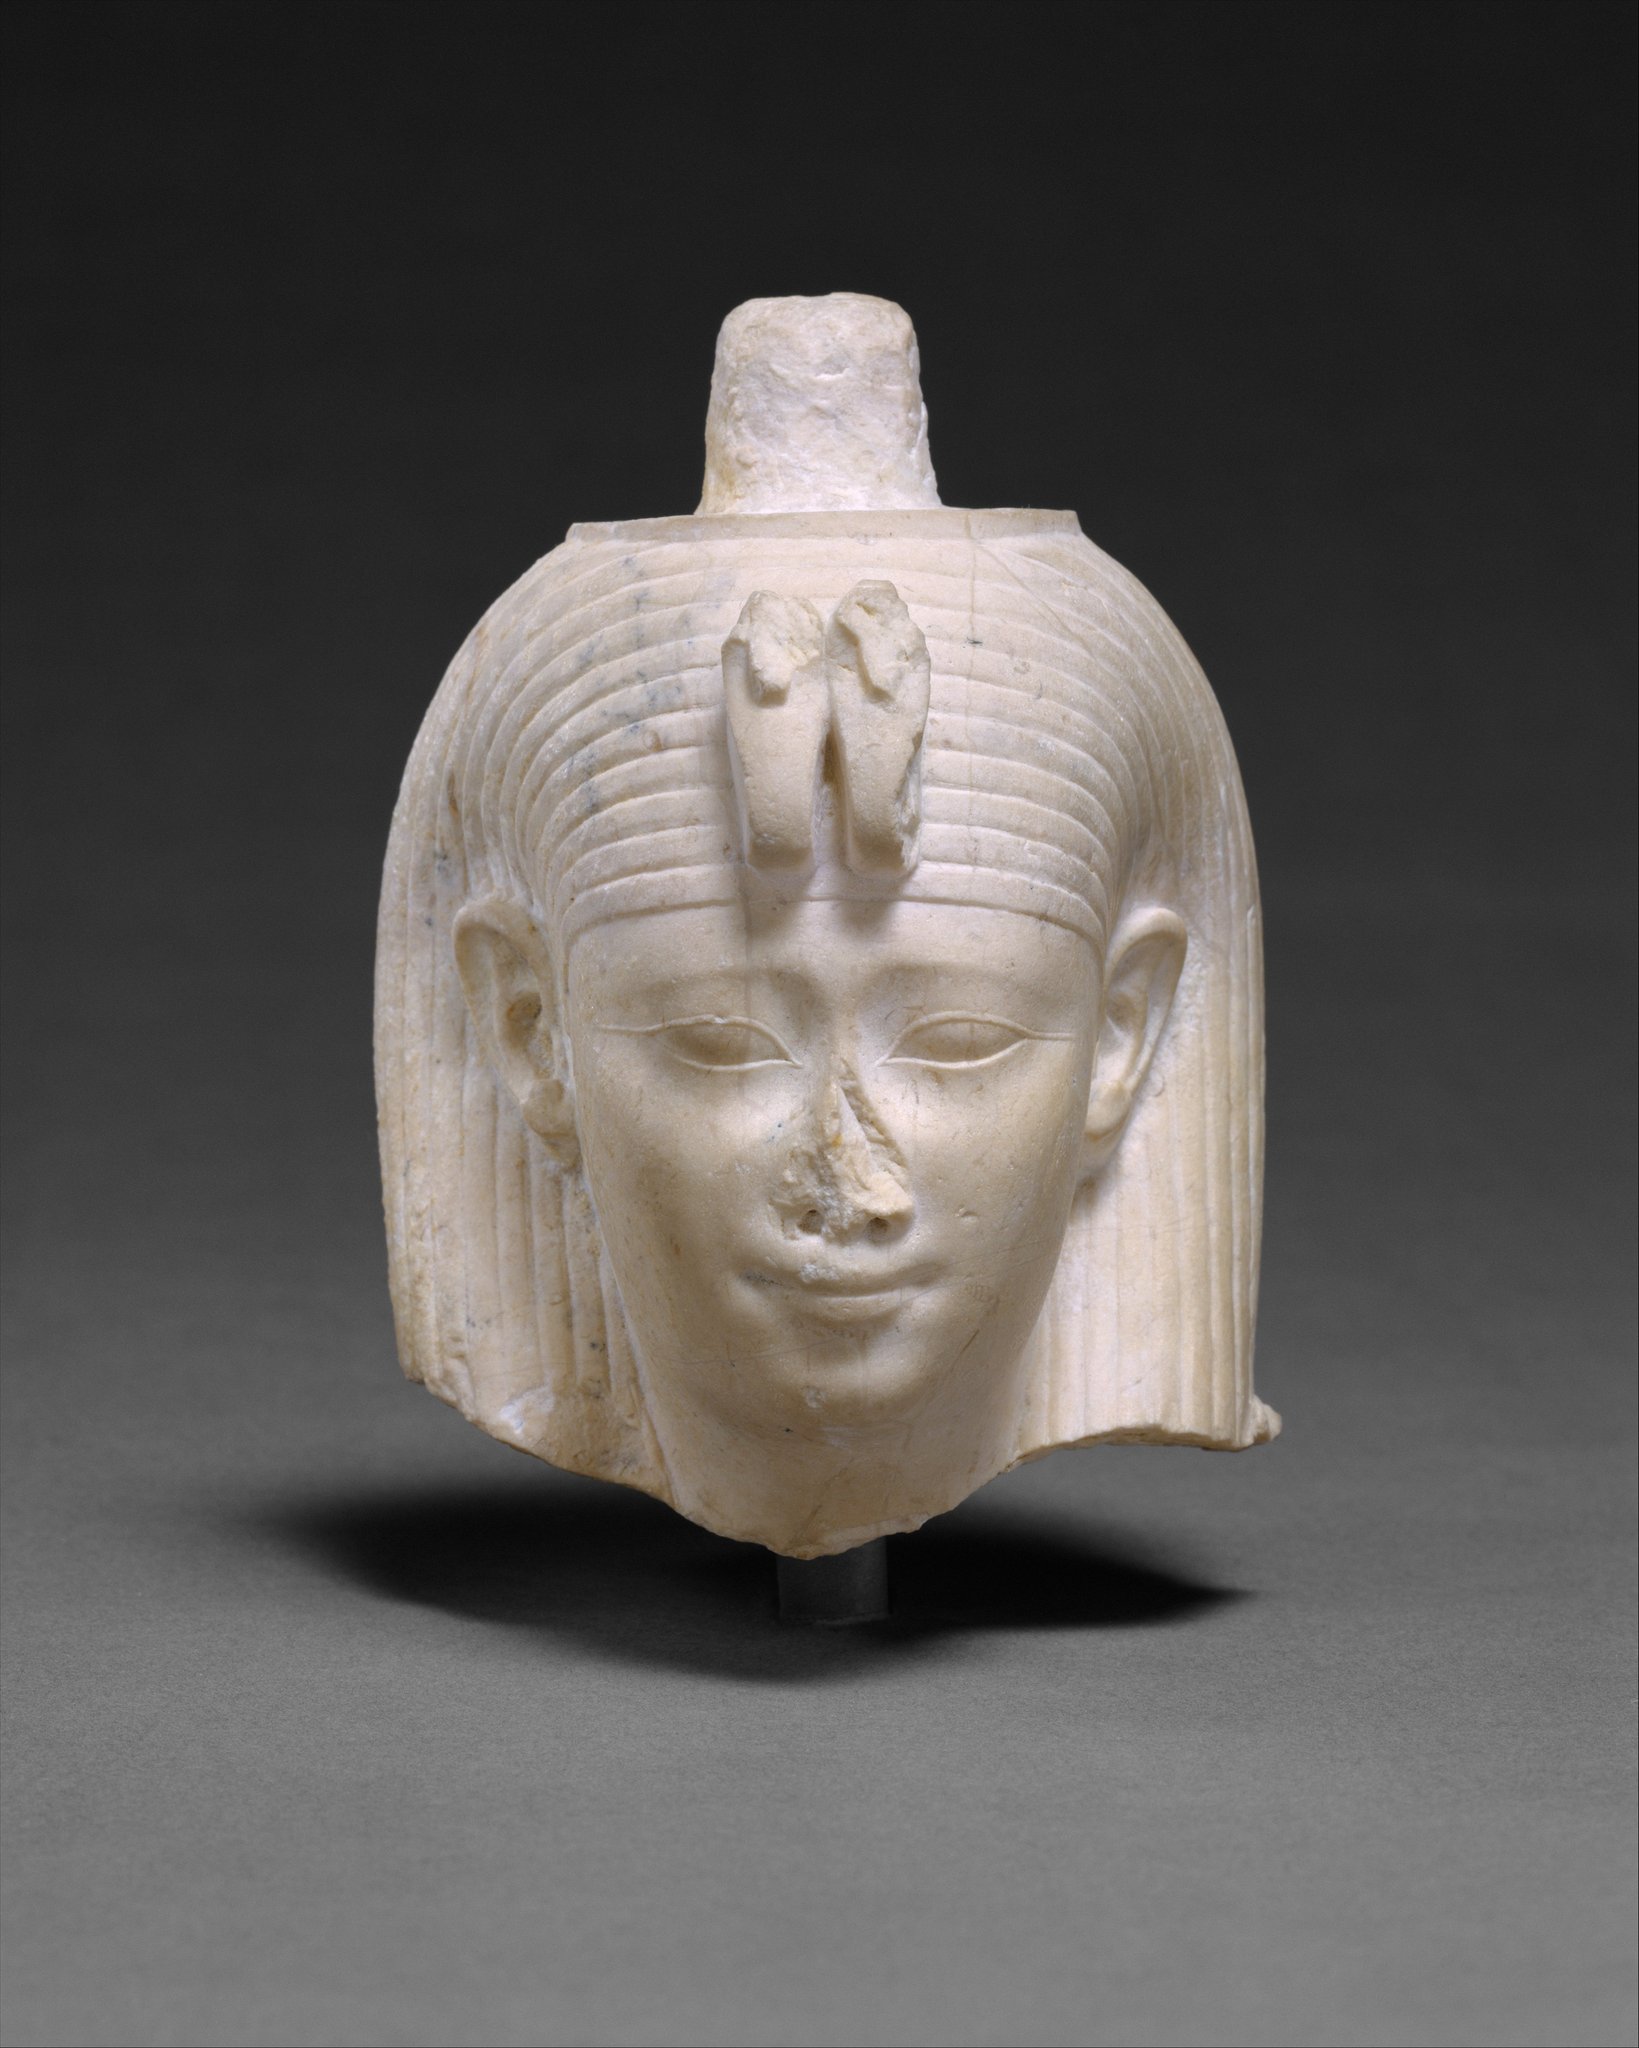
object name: head of a statue of arsinoe ii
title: Head Attributed to Arsinoe II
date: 278-270 BCE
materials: limestone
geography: egypt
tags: heads,women